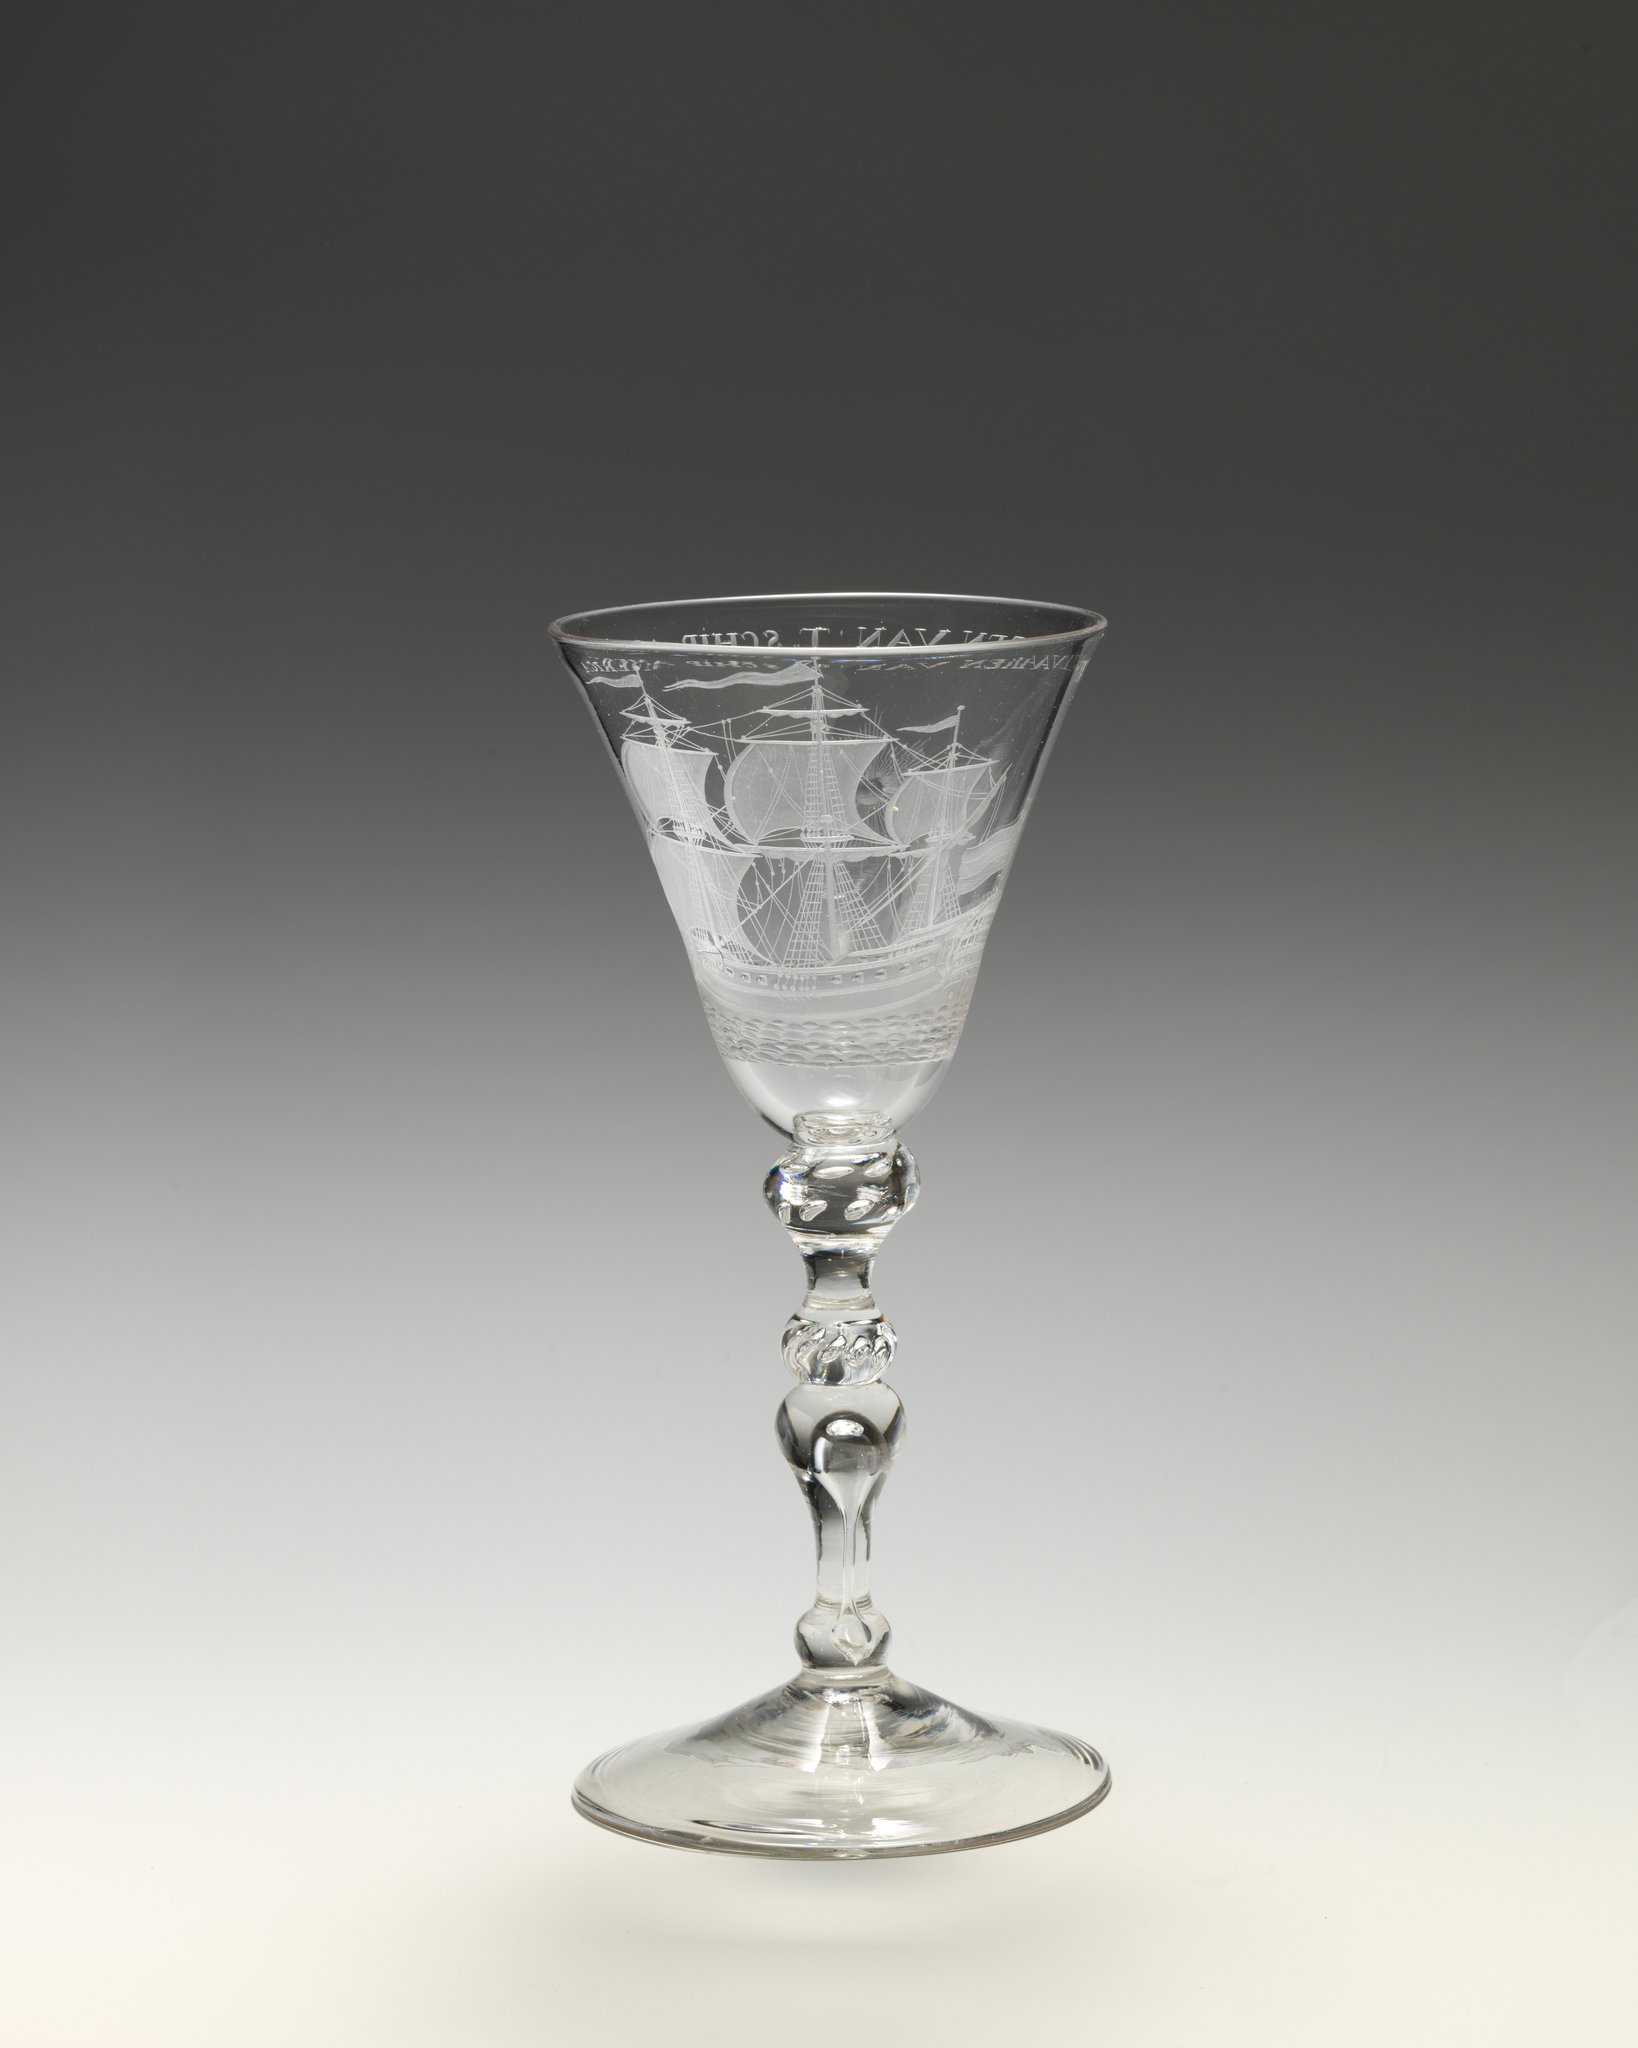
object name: goblet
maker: dagnia family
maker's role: maker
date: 1767-1800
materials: glass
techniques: engraving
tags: ships